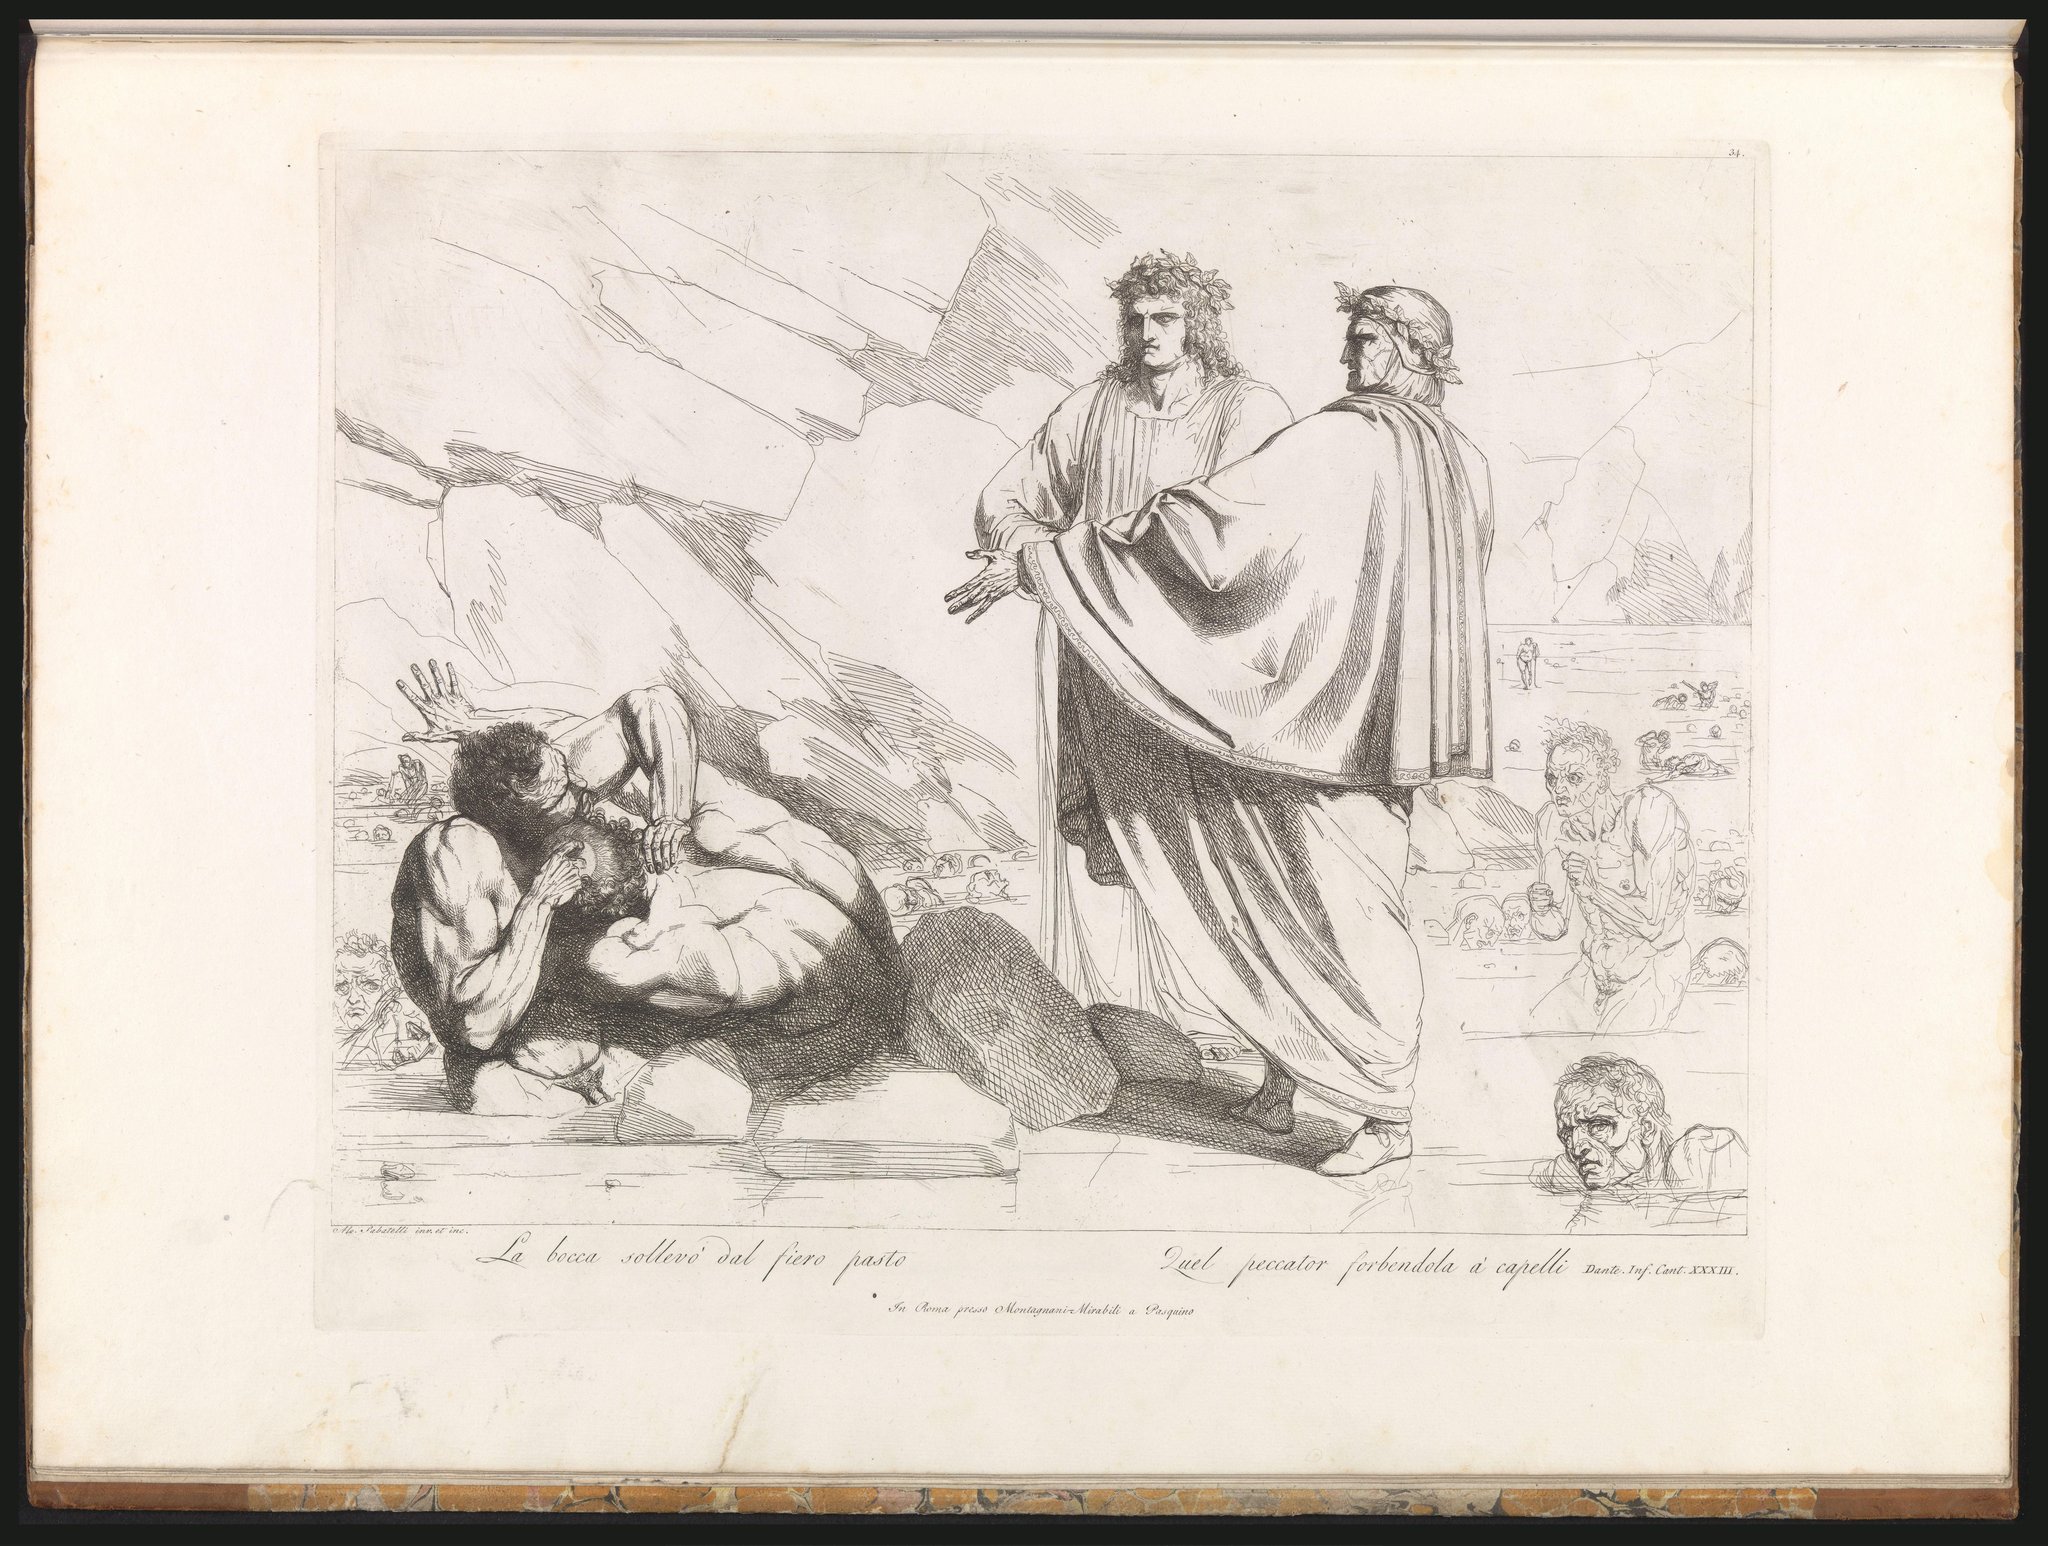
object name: print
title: Dante's Inferno: verraders in het ijs van de Cocytus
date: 1804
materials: paper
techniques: etching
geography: rome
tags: (scenes from) specific works of literature: dante, divina commedia, virgil, dante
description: Dante's Inferno: Dante en Vergilius bij het bevroren water van de Cocytus. Ugolino della Gherardesca knaagt in het ijs aan het hoofd van aartsbisschop Ruggieri (Canto 33). Prent nr. 34 op blad 20 in het album 'Raccolta di Soggetti Pittorici', een prentalbum met 42 genummerde etsen op 28 pagina's van Luigi Sabatelli (I) zelf en van leerlingen naar diens ontwerp.